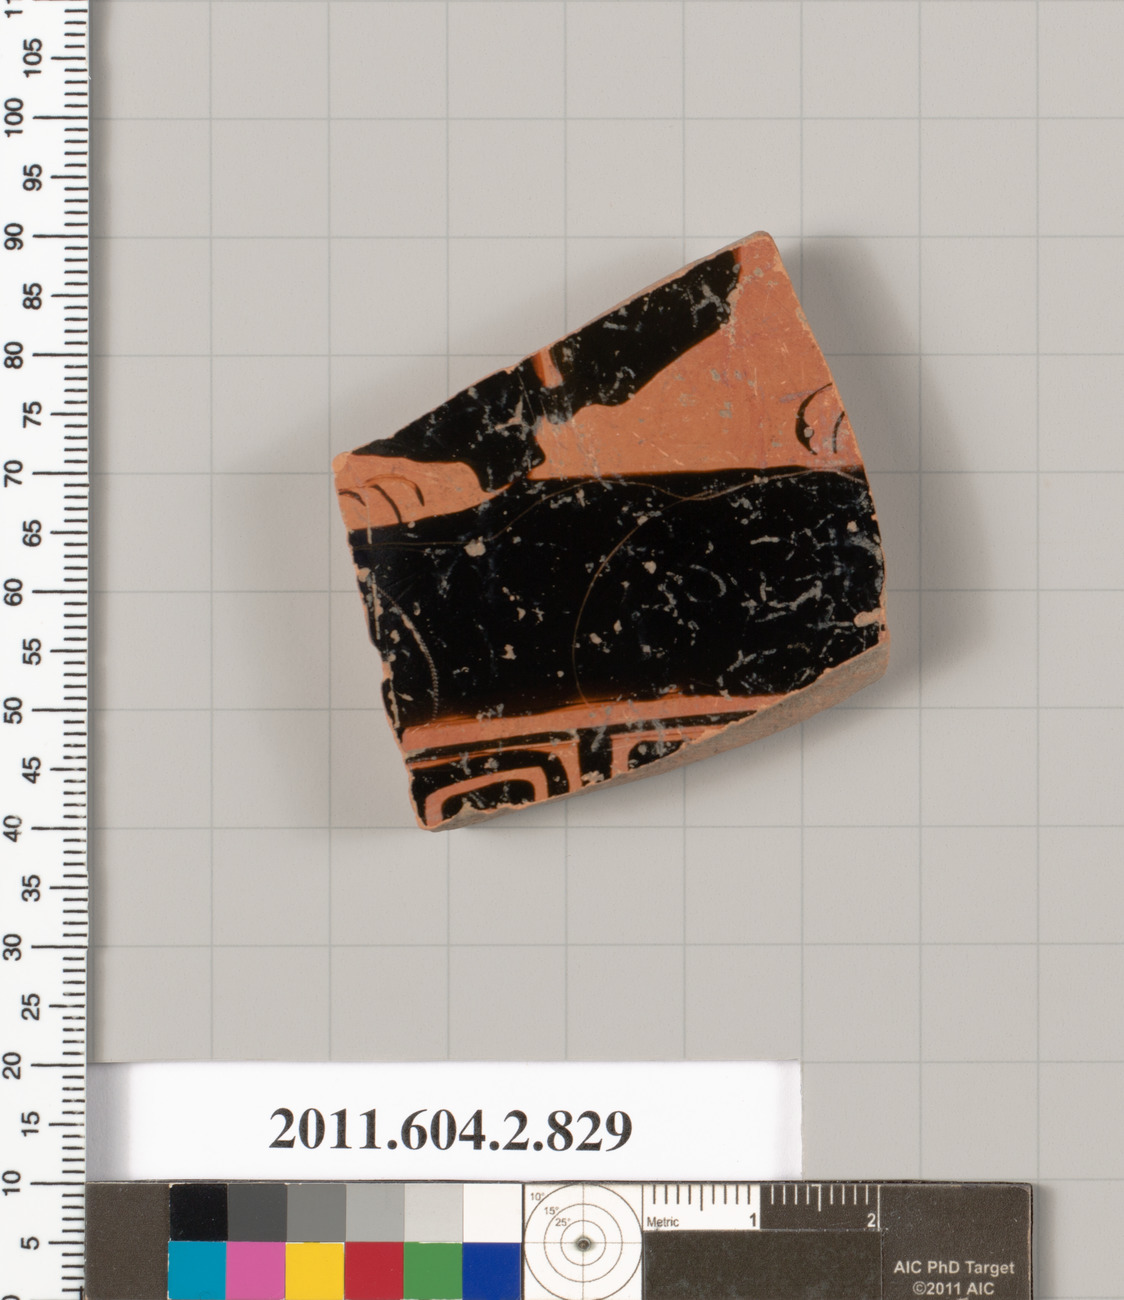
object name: bell krater fragment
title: Terracotta fragment of a bell-krater (bowl for mixing wine and water)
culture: greek, attic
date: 450-430 BCE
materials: terracotta